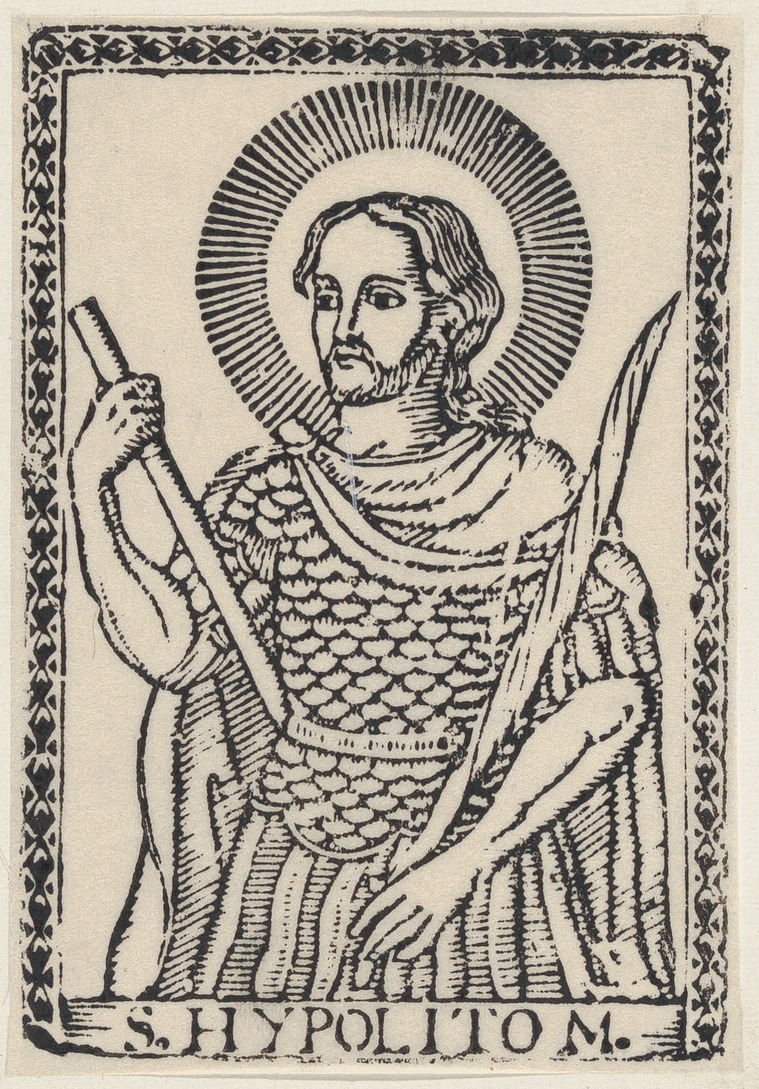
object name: print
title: Saint Hippolytus of Rome, martyr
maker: anonymous, mexican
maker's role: artist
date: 1801-1900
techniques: woodcut